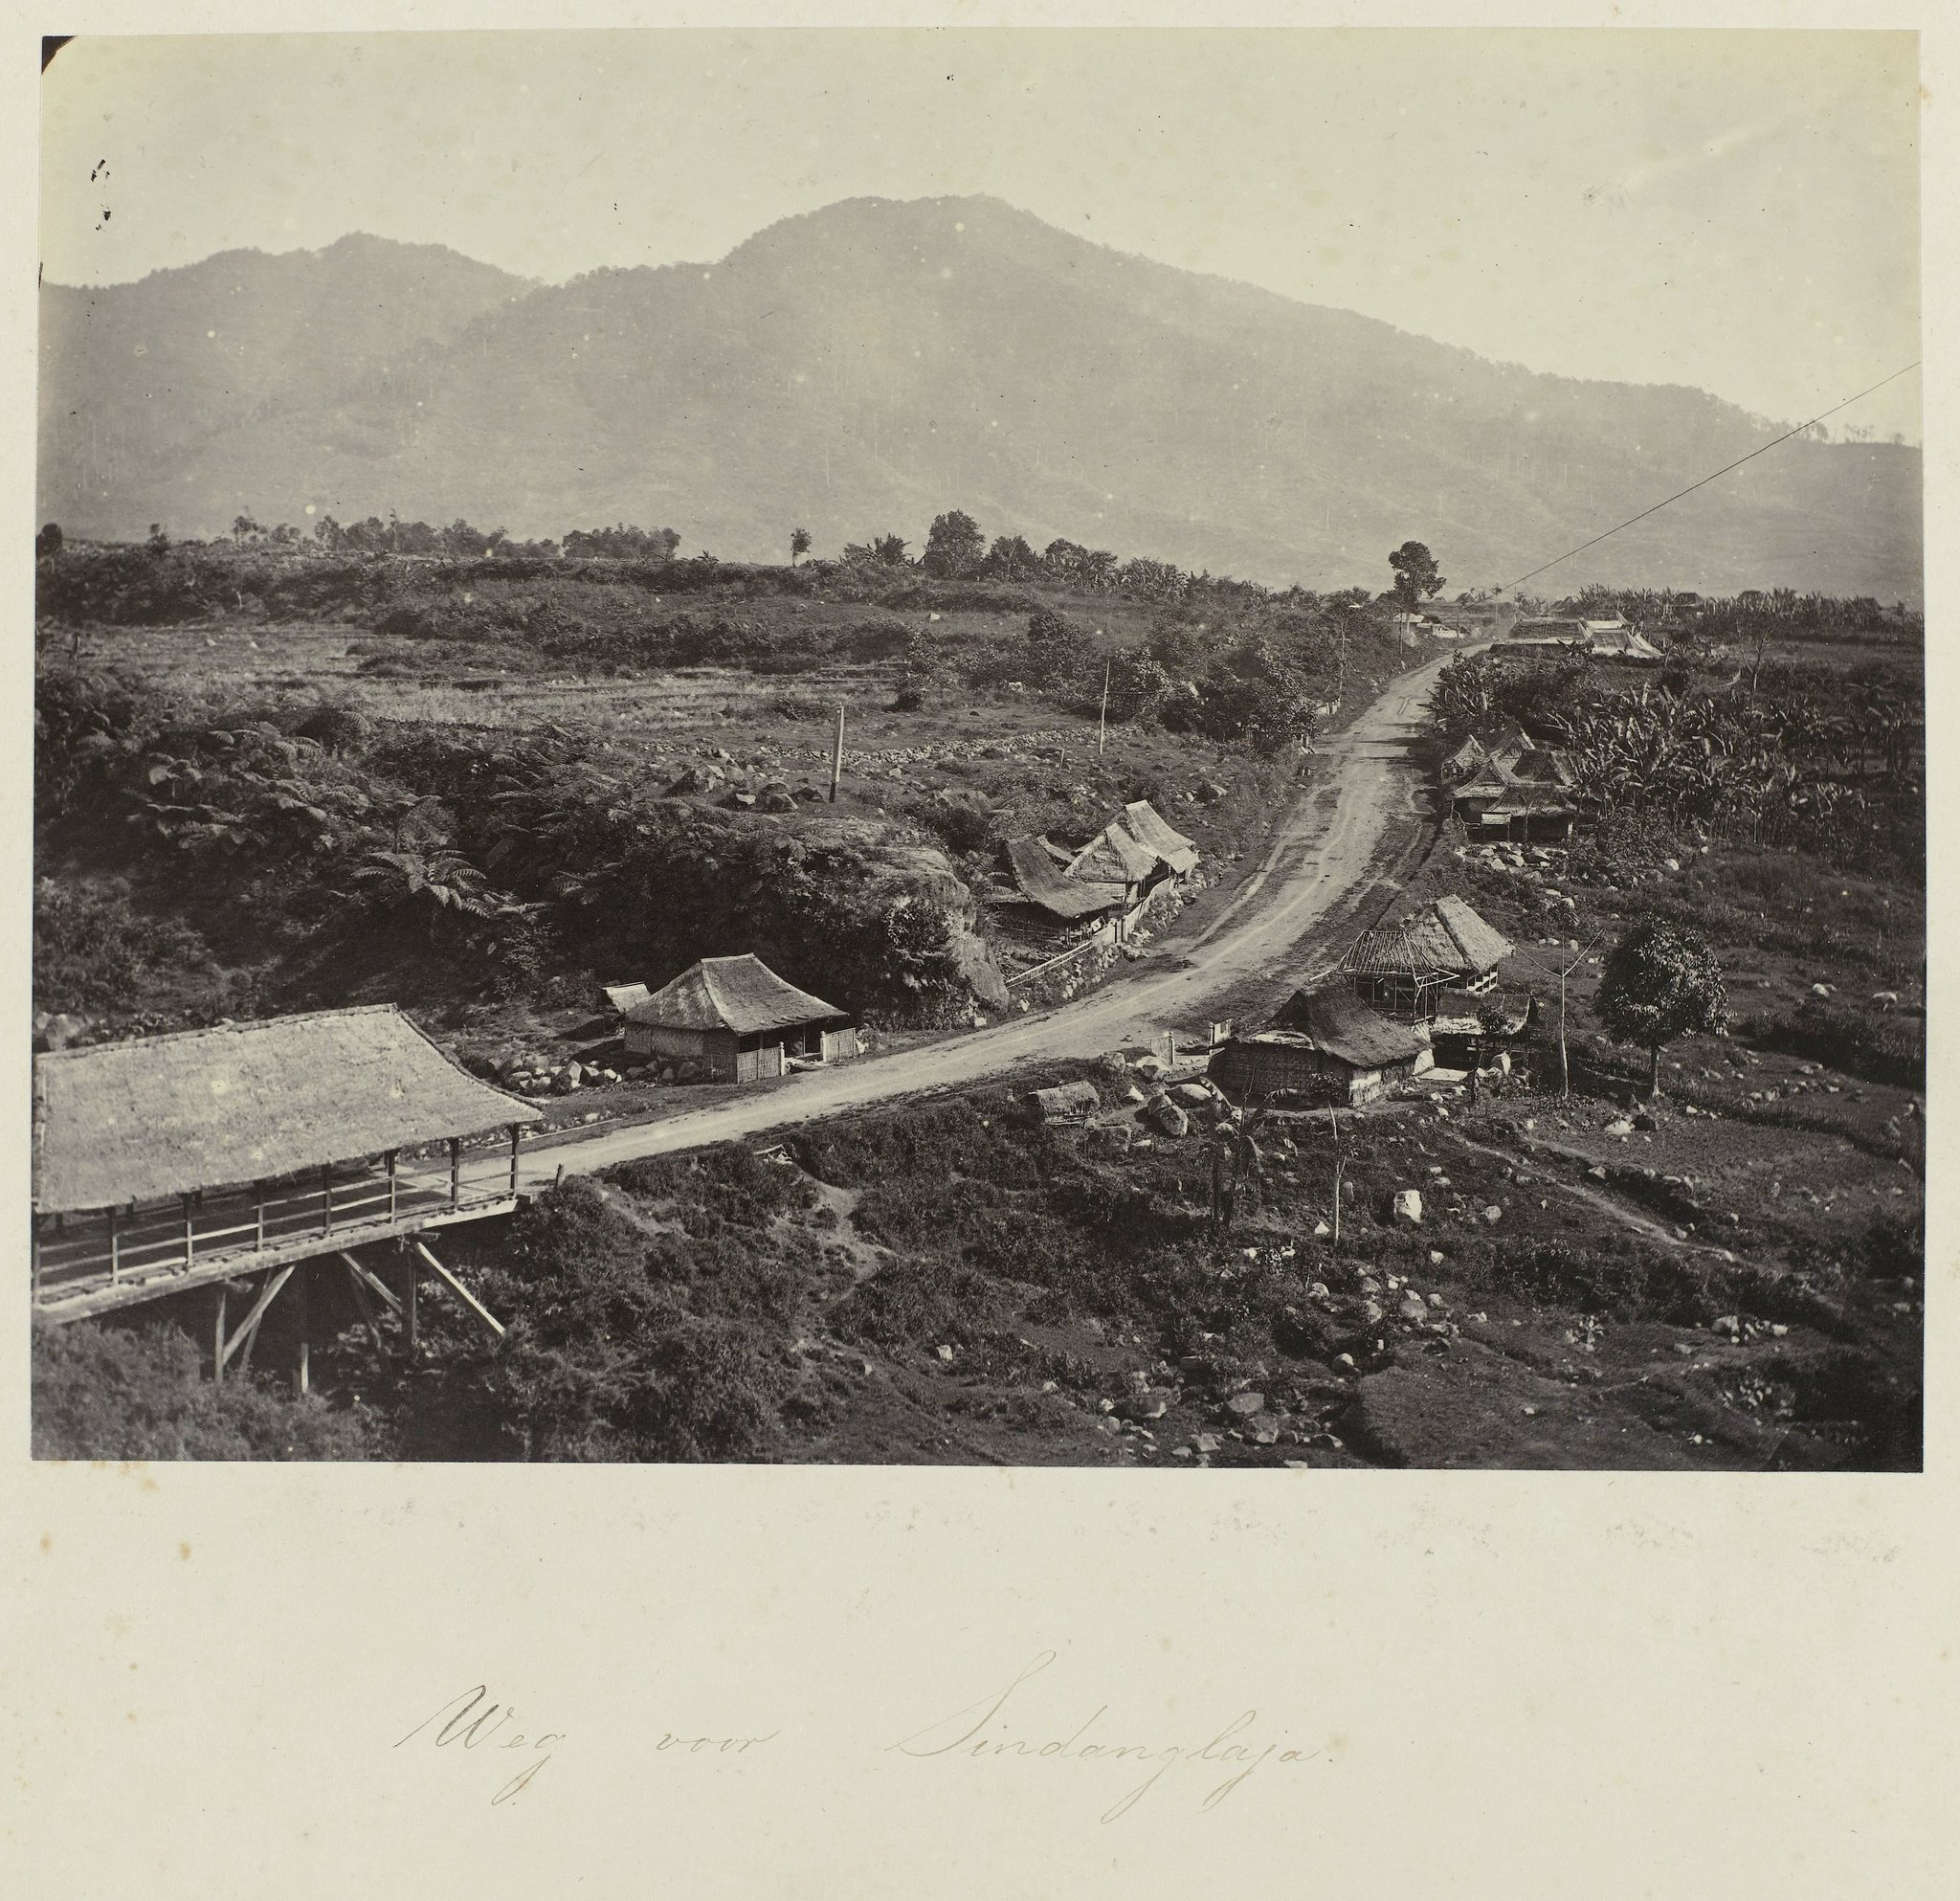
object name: photograph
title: Weg voor Sindanglaja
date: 1863-1869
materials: photographic support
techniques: albumen print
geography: sindanglaya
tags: village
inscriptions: inscription: ‘Weg voor Sindanglaja.’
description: Gezicht op de weg bij Sindanglaja. Onderdeel van het groene fotoalbum met foto's van Java, uit het bezit van apotheker Specht-Grijp, die in 1865 vanuit Batavia naar Nederland terugkeerde.